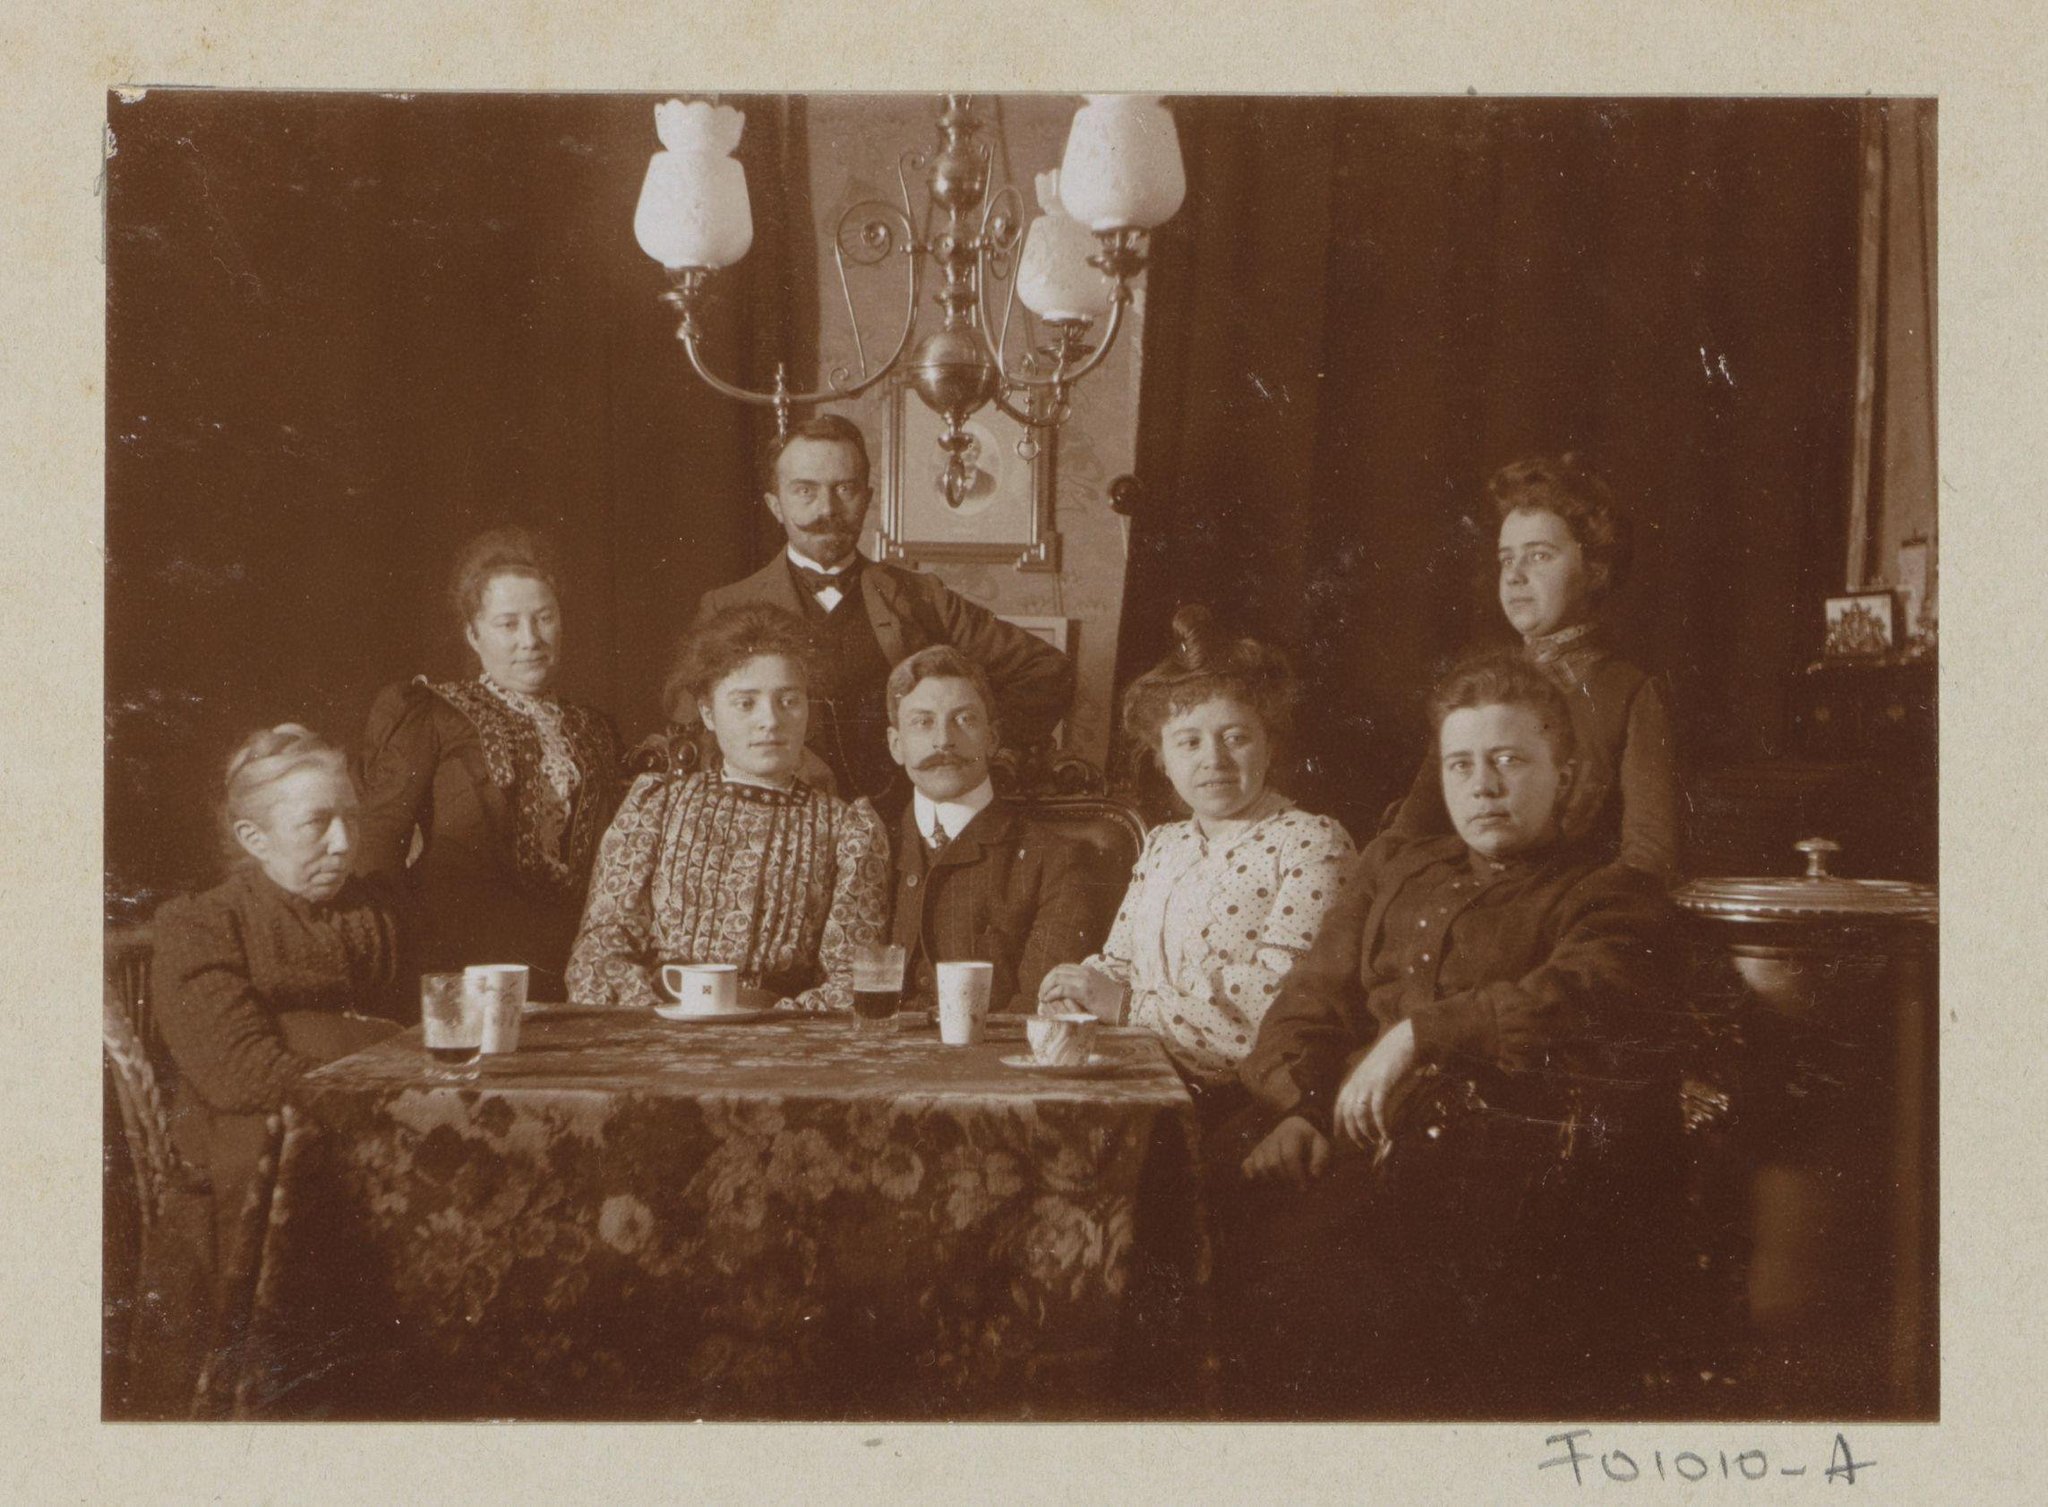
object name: photograph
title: Mannen en vrouwen achter een tafel in een woonkamer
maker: Anonymous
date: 1900-1910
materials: photographic support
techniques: collodion silver print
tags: interior of the house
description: Onderdeel van Familiealbum met onder meer foto's van Wijnhandel Kraaij & Co. Bordeaux-Amsterdam.